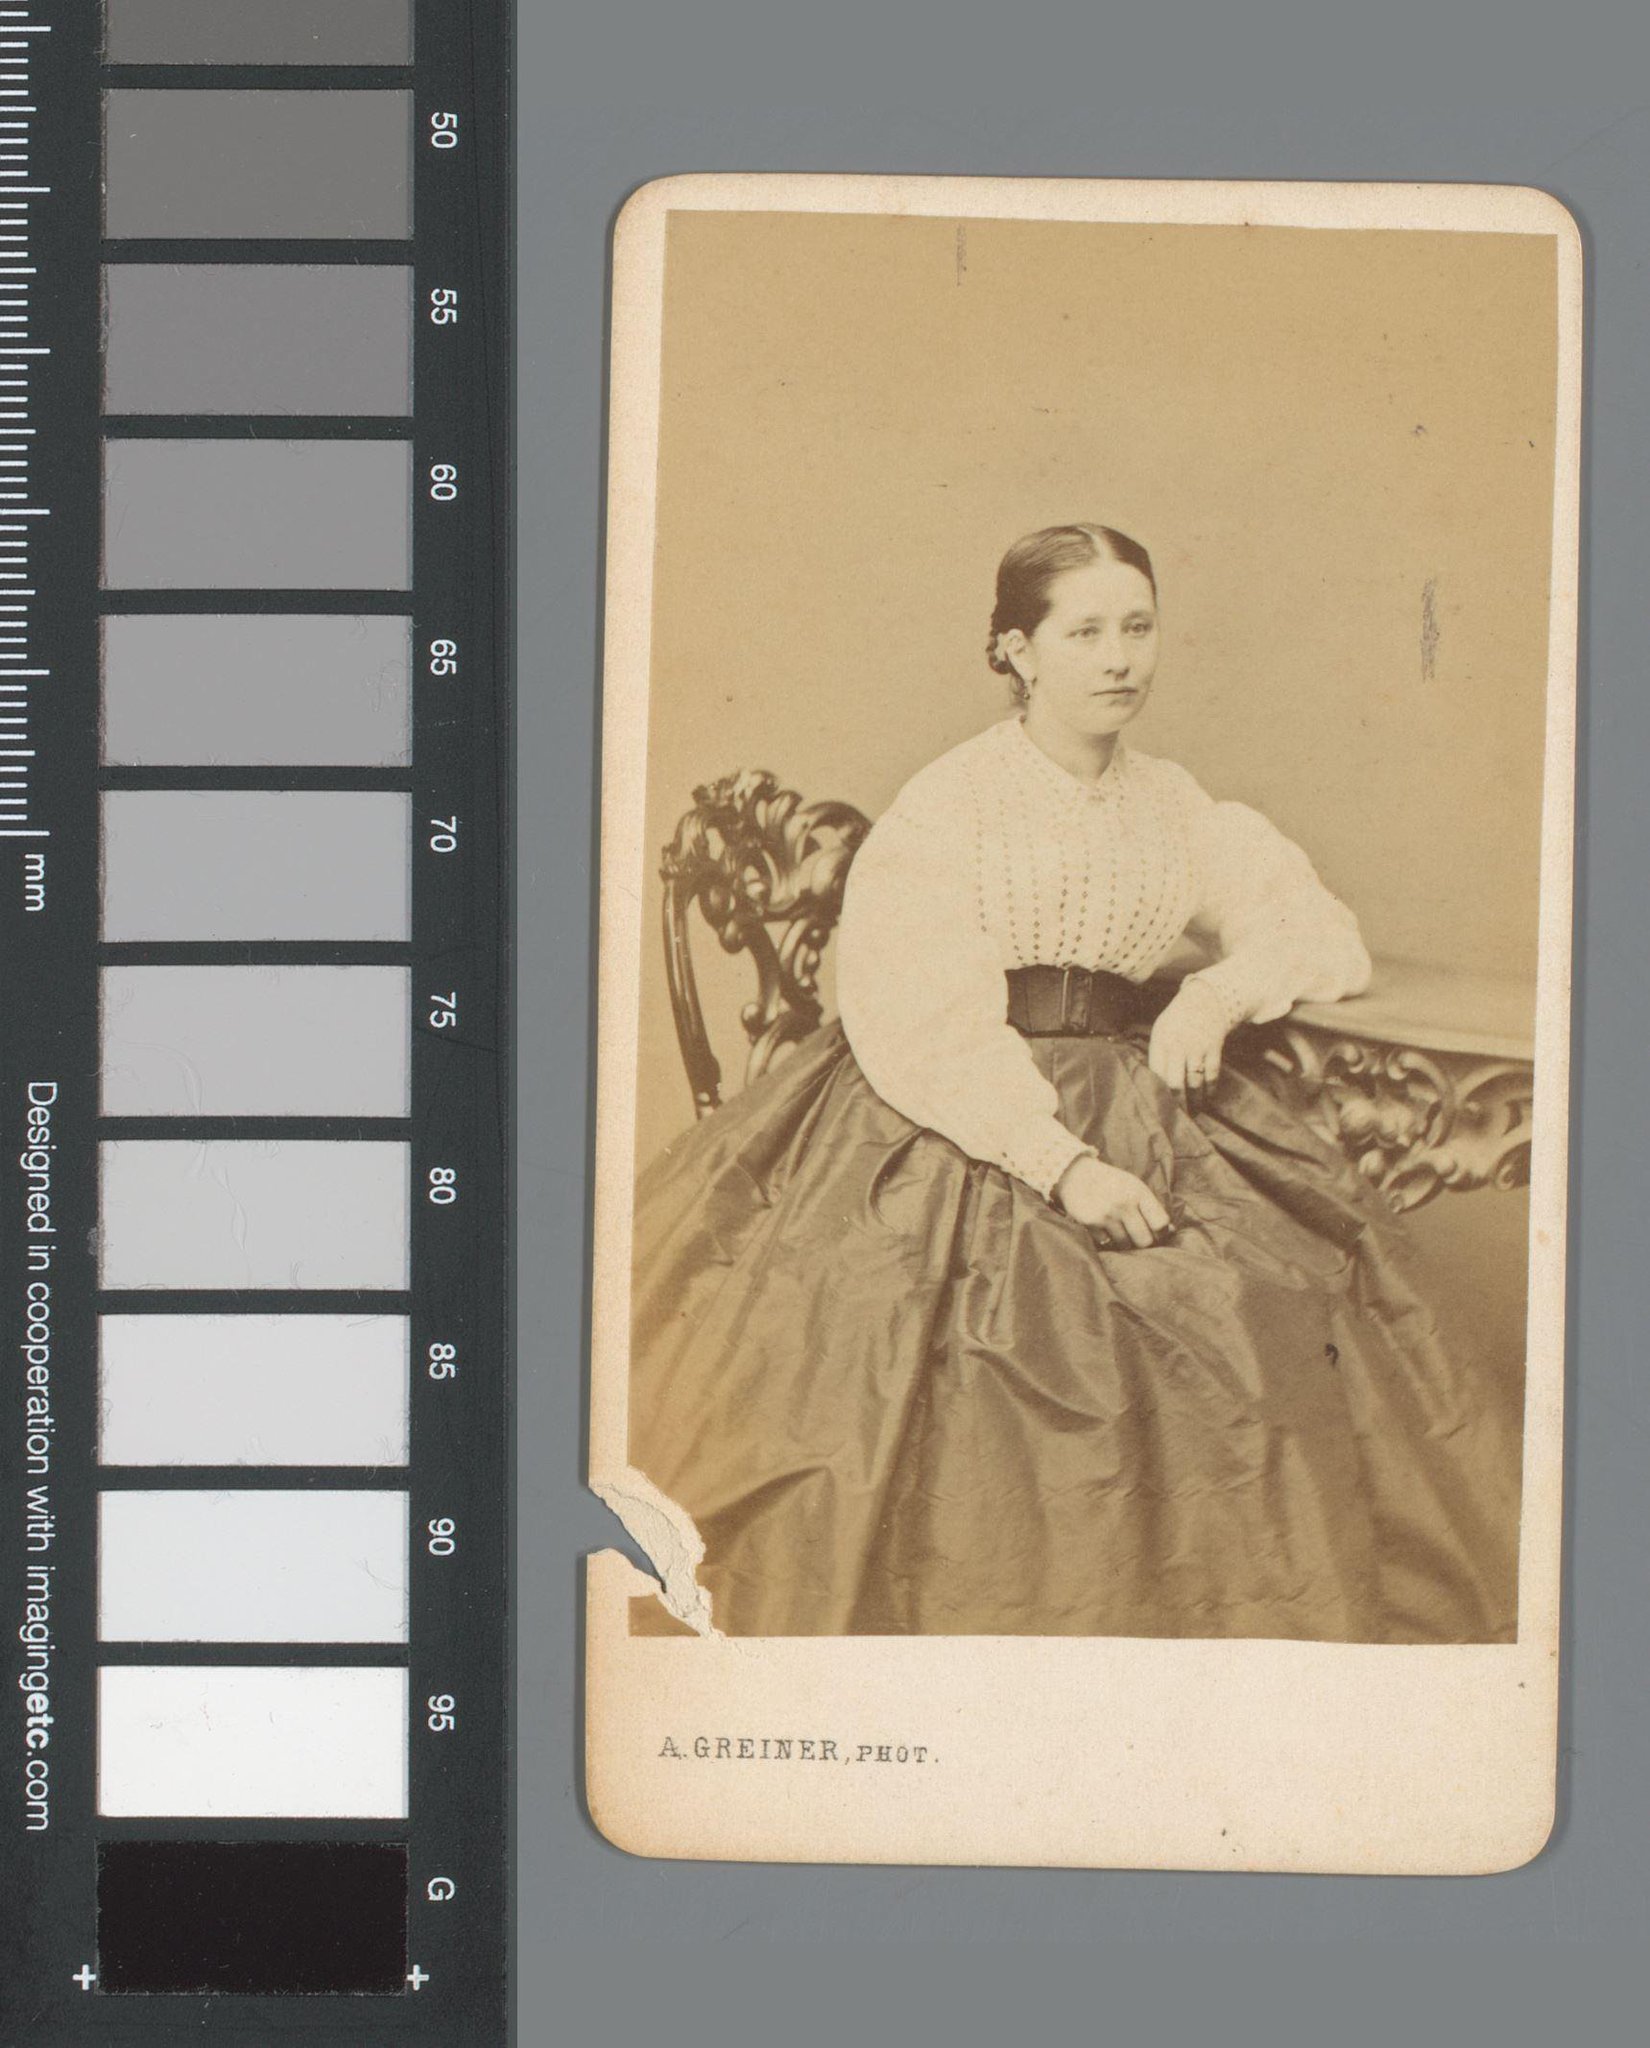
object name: photograph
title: Portret van Johanna Geertruida Jonker Nije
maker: albert greiner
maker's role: fotograaf, fotostudio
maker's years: 1833-1890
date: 1861-1874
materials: cardboard, photographic support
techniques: albumen print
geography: amsterdam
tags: historical persons, amsterdam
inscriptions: annotation: ‘grootmoeder J.G. Jonker-Nije/ vrouw van opa luc’, workshop stamp: ‘A. Greiner/ Photograf/ Nieuwendijk L.87/ Amsterdam’